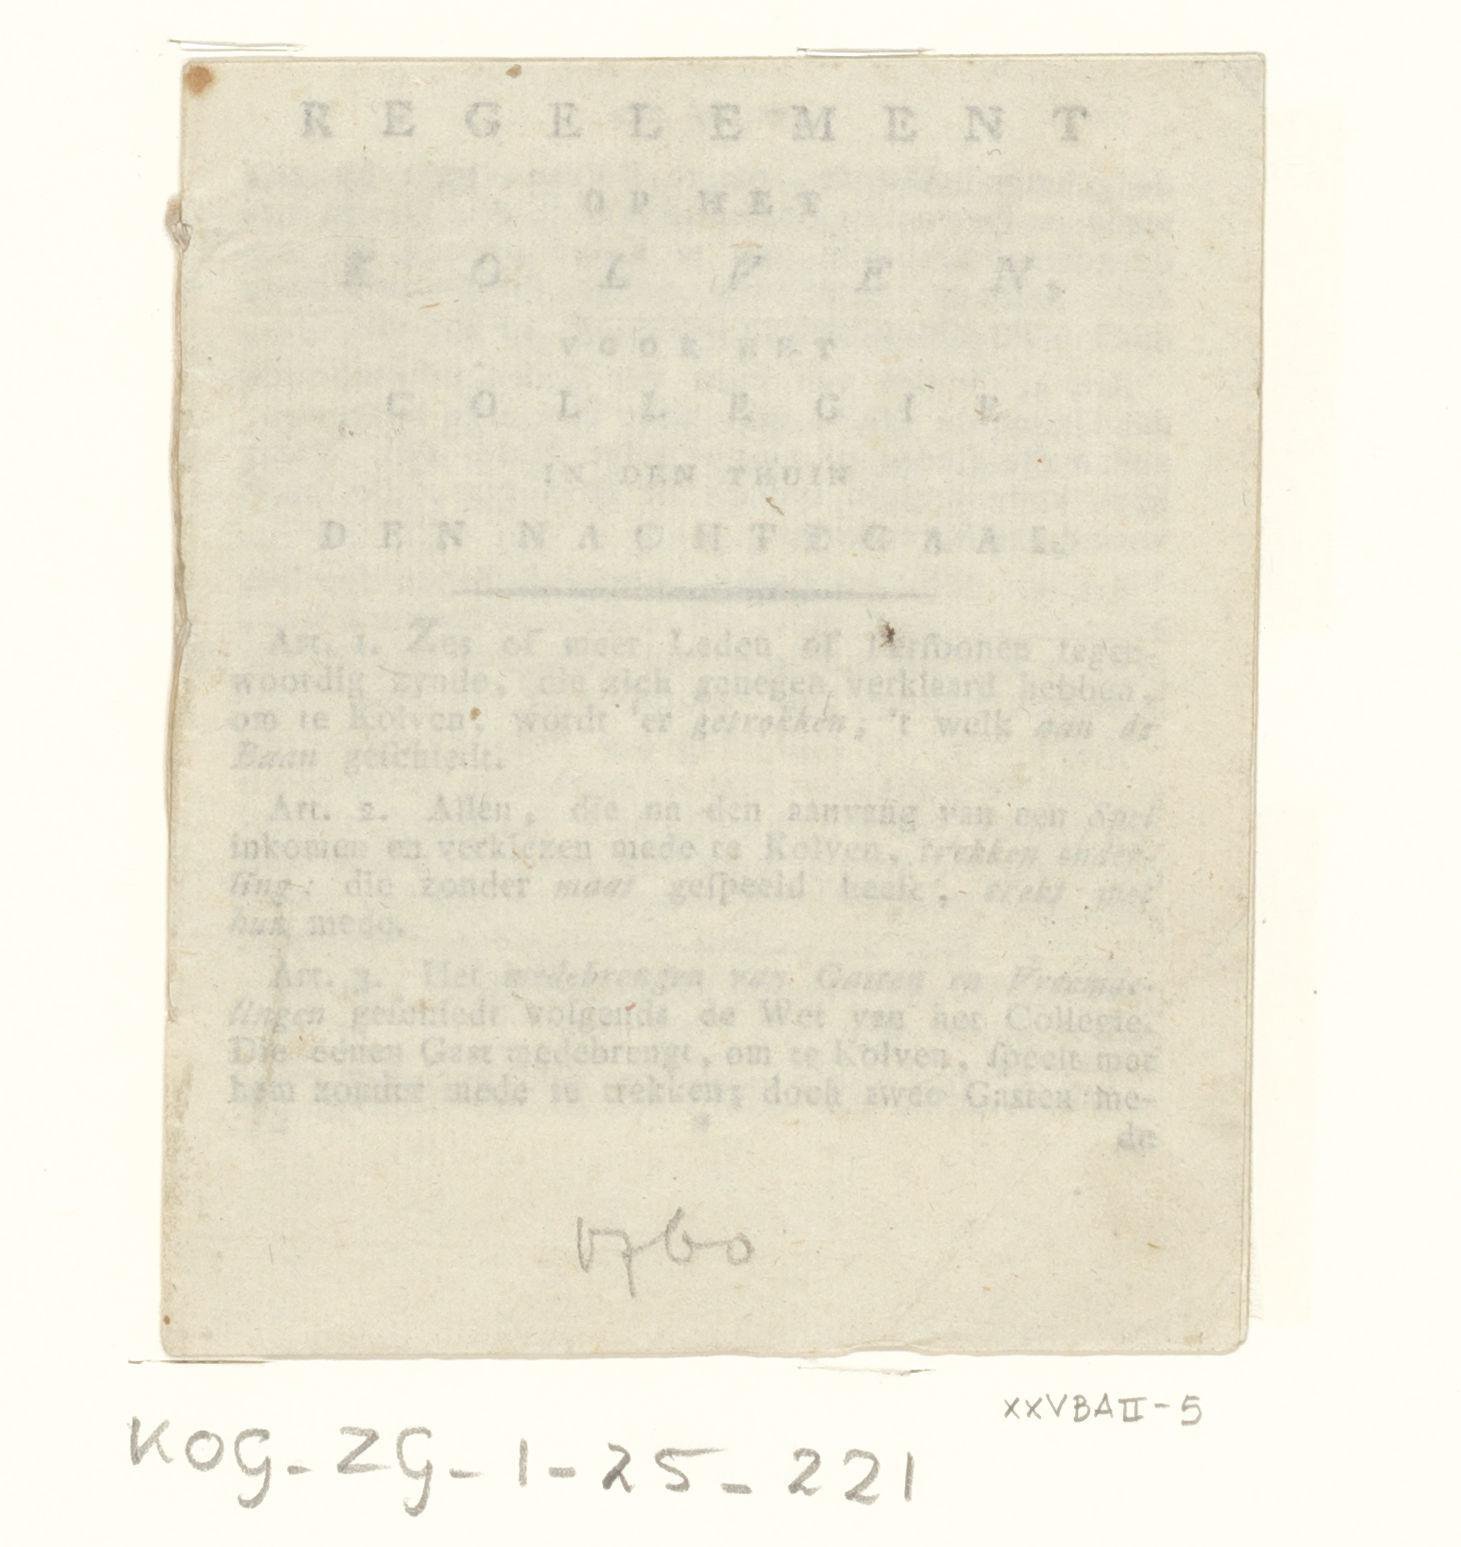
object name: book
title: Regelementen van kolf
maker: Anonymous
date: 1700-1799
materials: paper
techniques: letterpress printing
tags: 'kolf' (ball game)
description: Onderwerpsrubrieken binnen de Atlas Zeden en Gewoonten: Zeden en Gewoonten in Engeren Zin, Spel en vermaak, Oud-Hollandsch volksspel, Kolven.